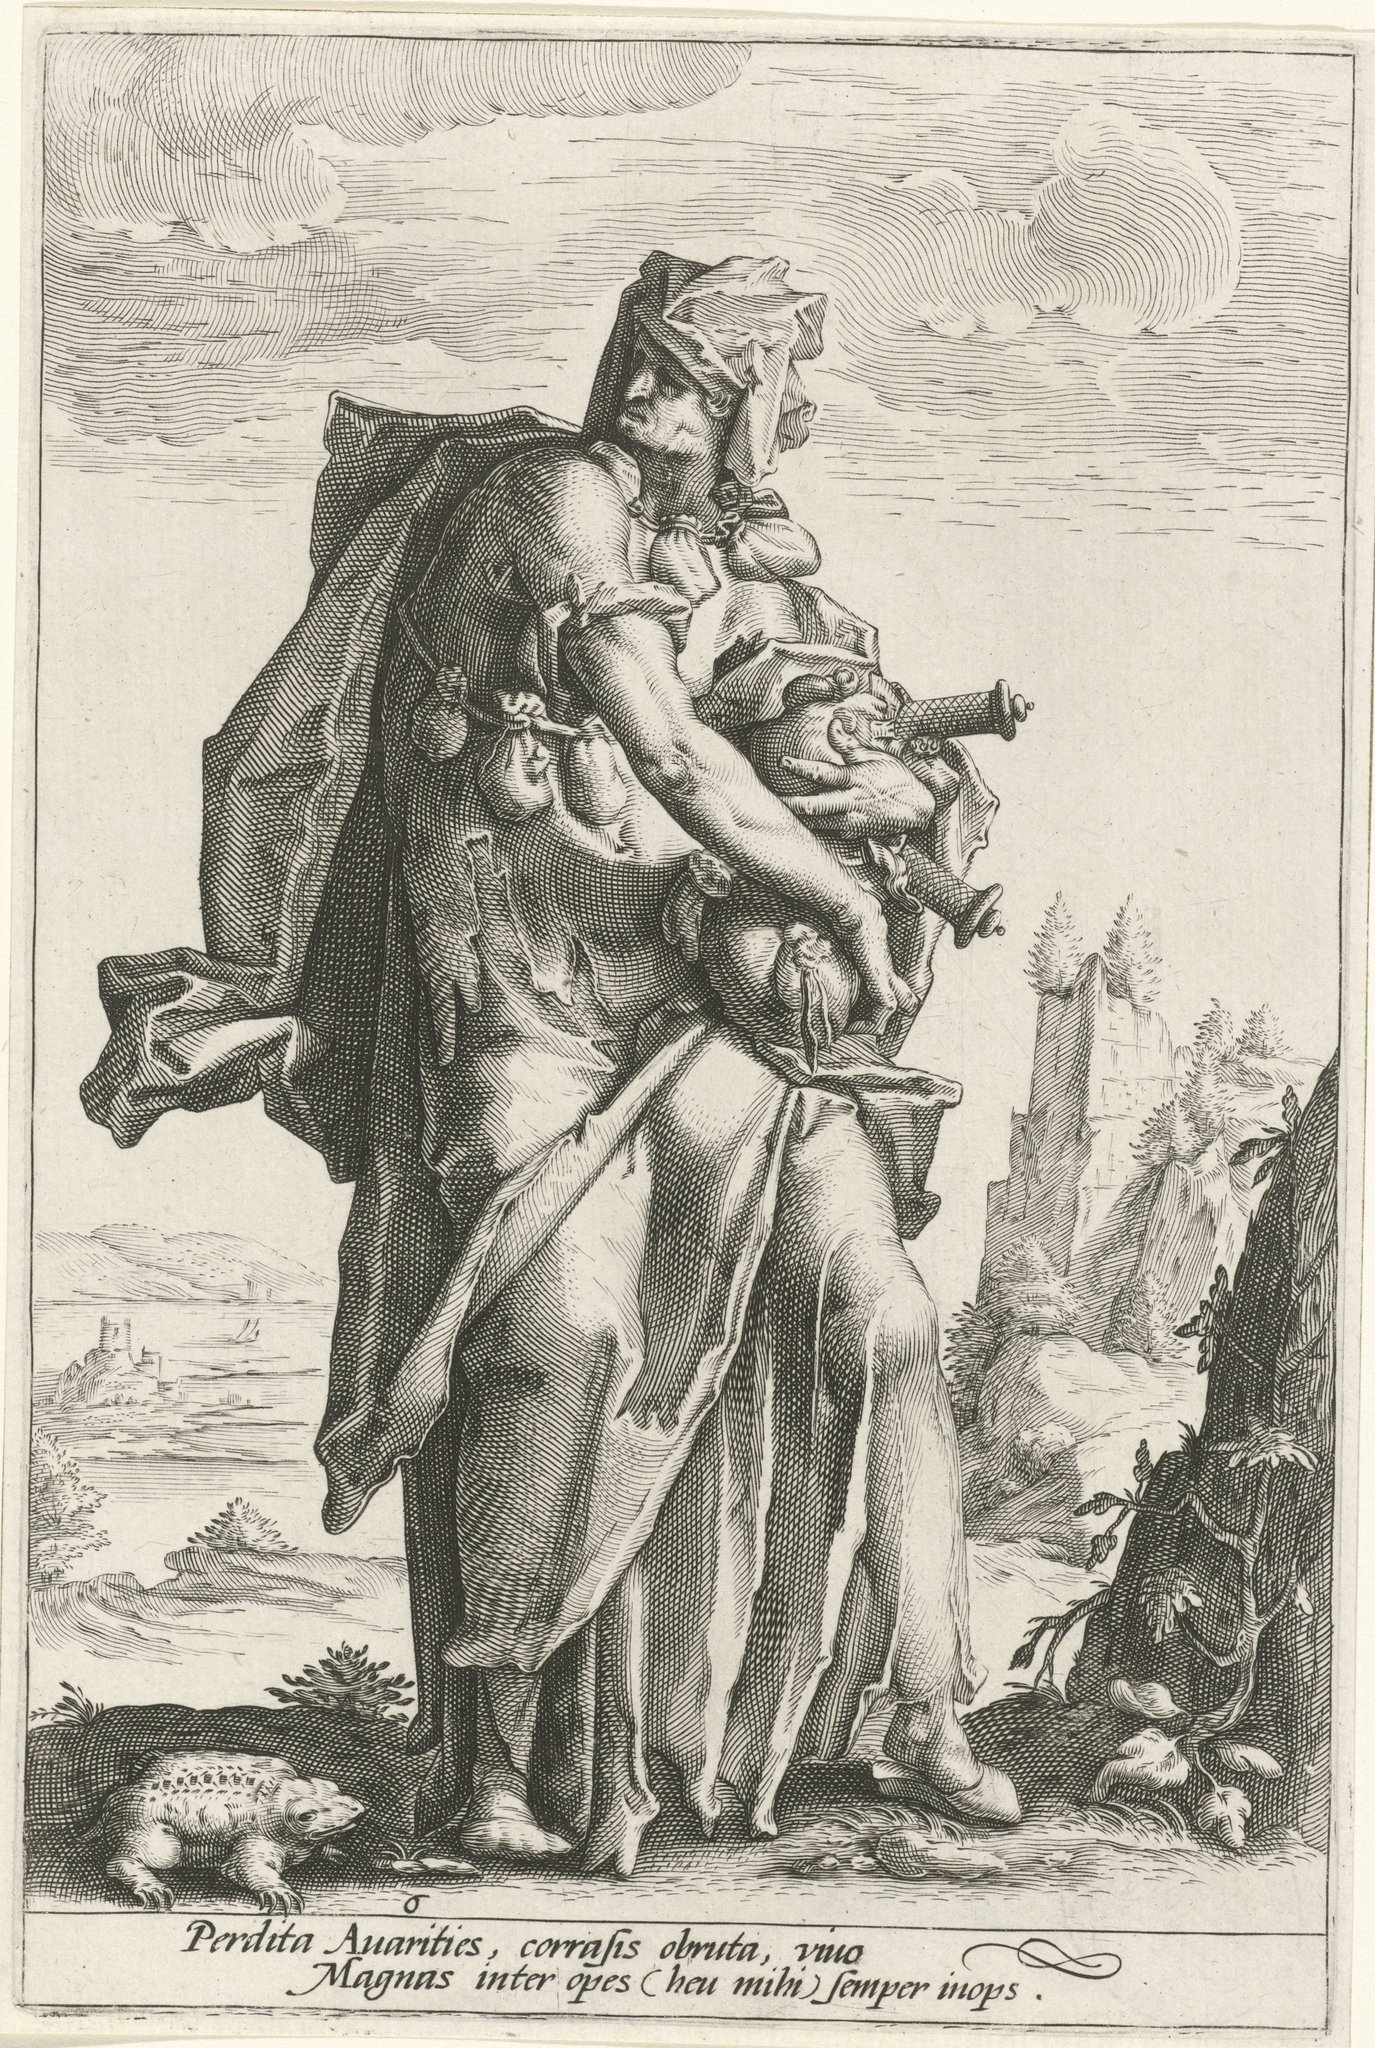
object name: print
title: Avarice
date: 1585-1589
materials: paper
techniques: engraving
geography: haarlem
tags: covetousness; 'avaritia' (ripa) ~ personification of one of the seven deadly sins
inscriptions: collector's mark: Lugt 240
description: Avaritia, or Greed, was widely perceived as the worst of the Seven Deadly Sins, since the desire for money was the root of all evil. This personification of Avarice (with her attribute, the toad) seems not to have any idea what she needs money for. Wealth has become a burden – a weight to be carried in bags strapped to her chest.